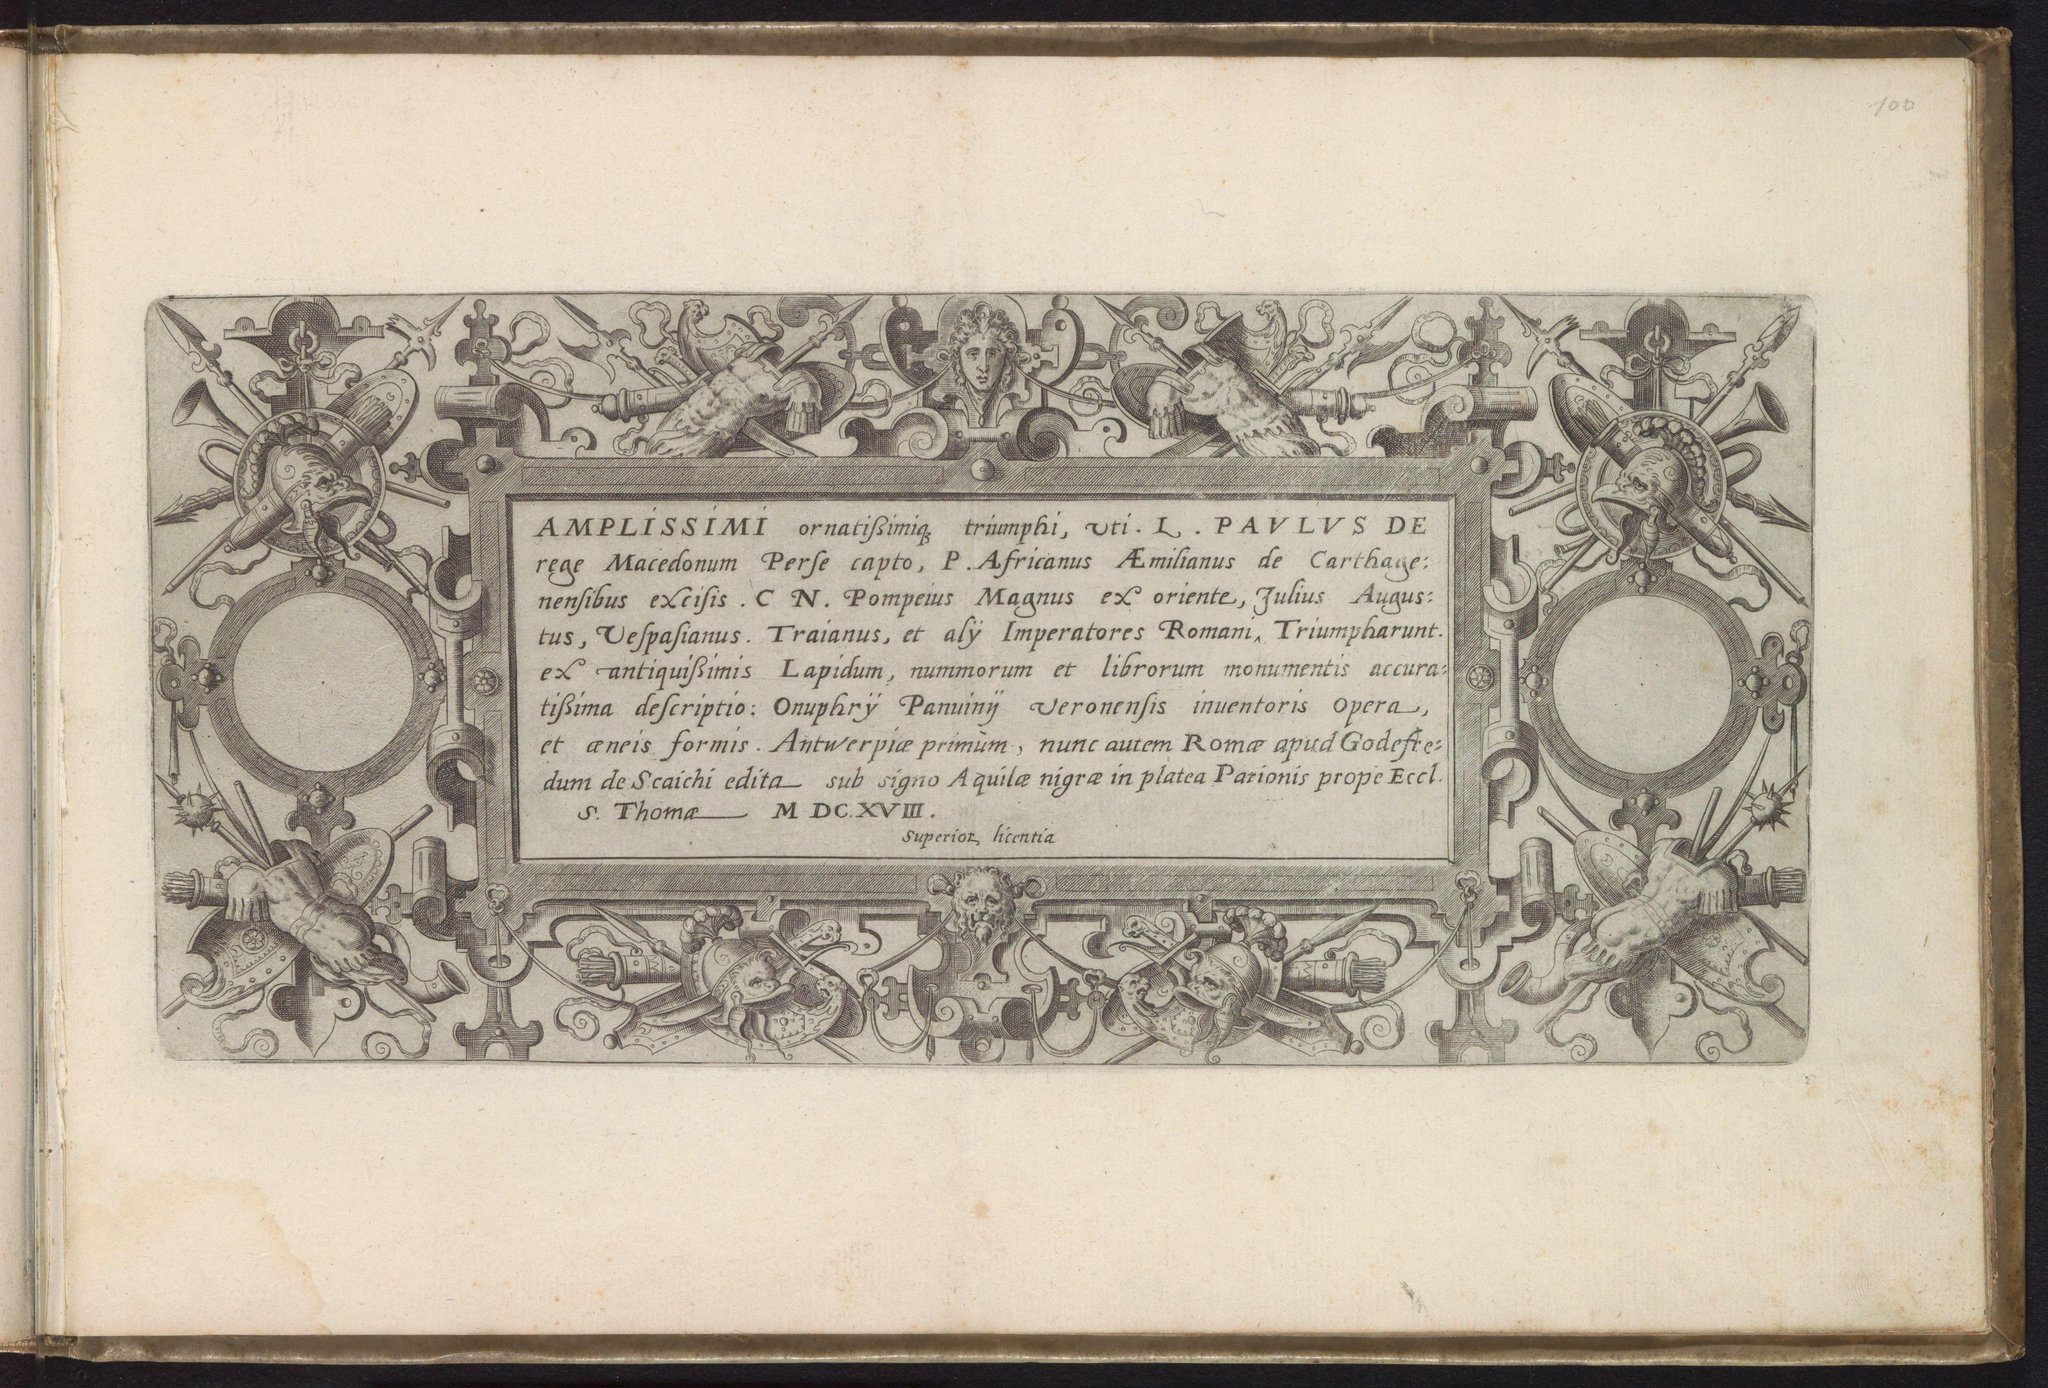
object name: titelprent, frontispice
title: Titelprent met ornamenteel kader met wapentuig en rolwerk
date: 1618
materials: paper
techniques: engraving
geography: rome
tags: armour, ornament ~ cartouche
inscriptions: date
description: Titel in ornamentele omlijsting met rolwerk, harnassen en wapens, geflankeerd door twee lege medaillons. Prent maakt deel uit van een album.